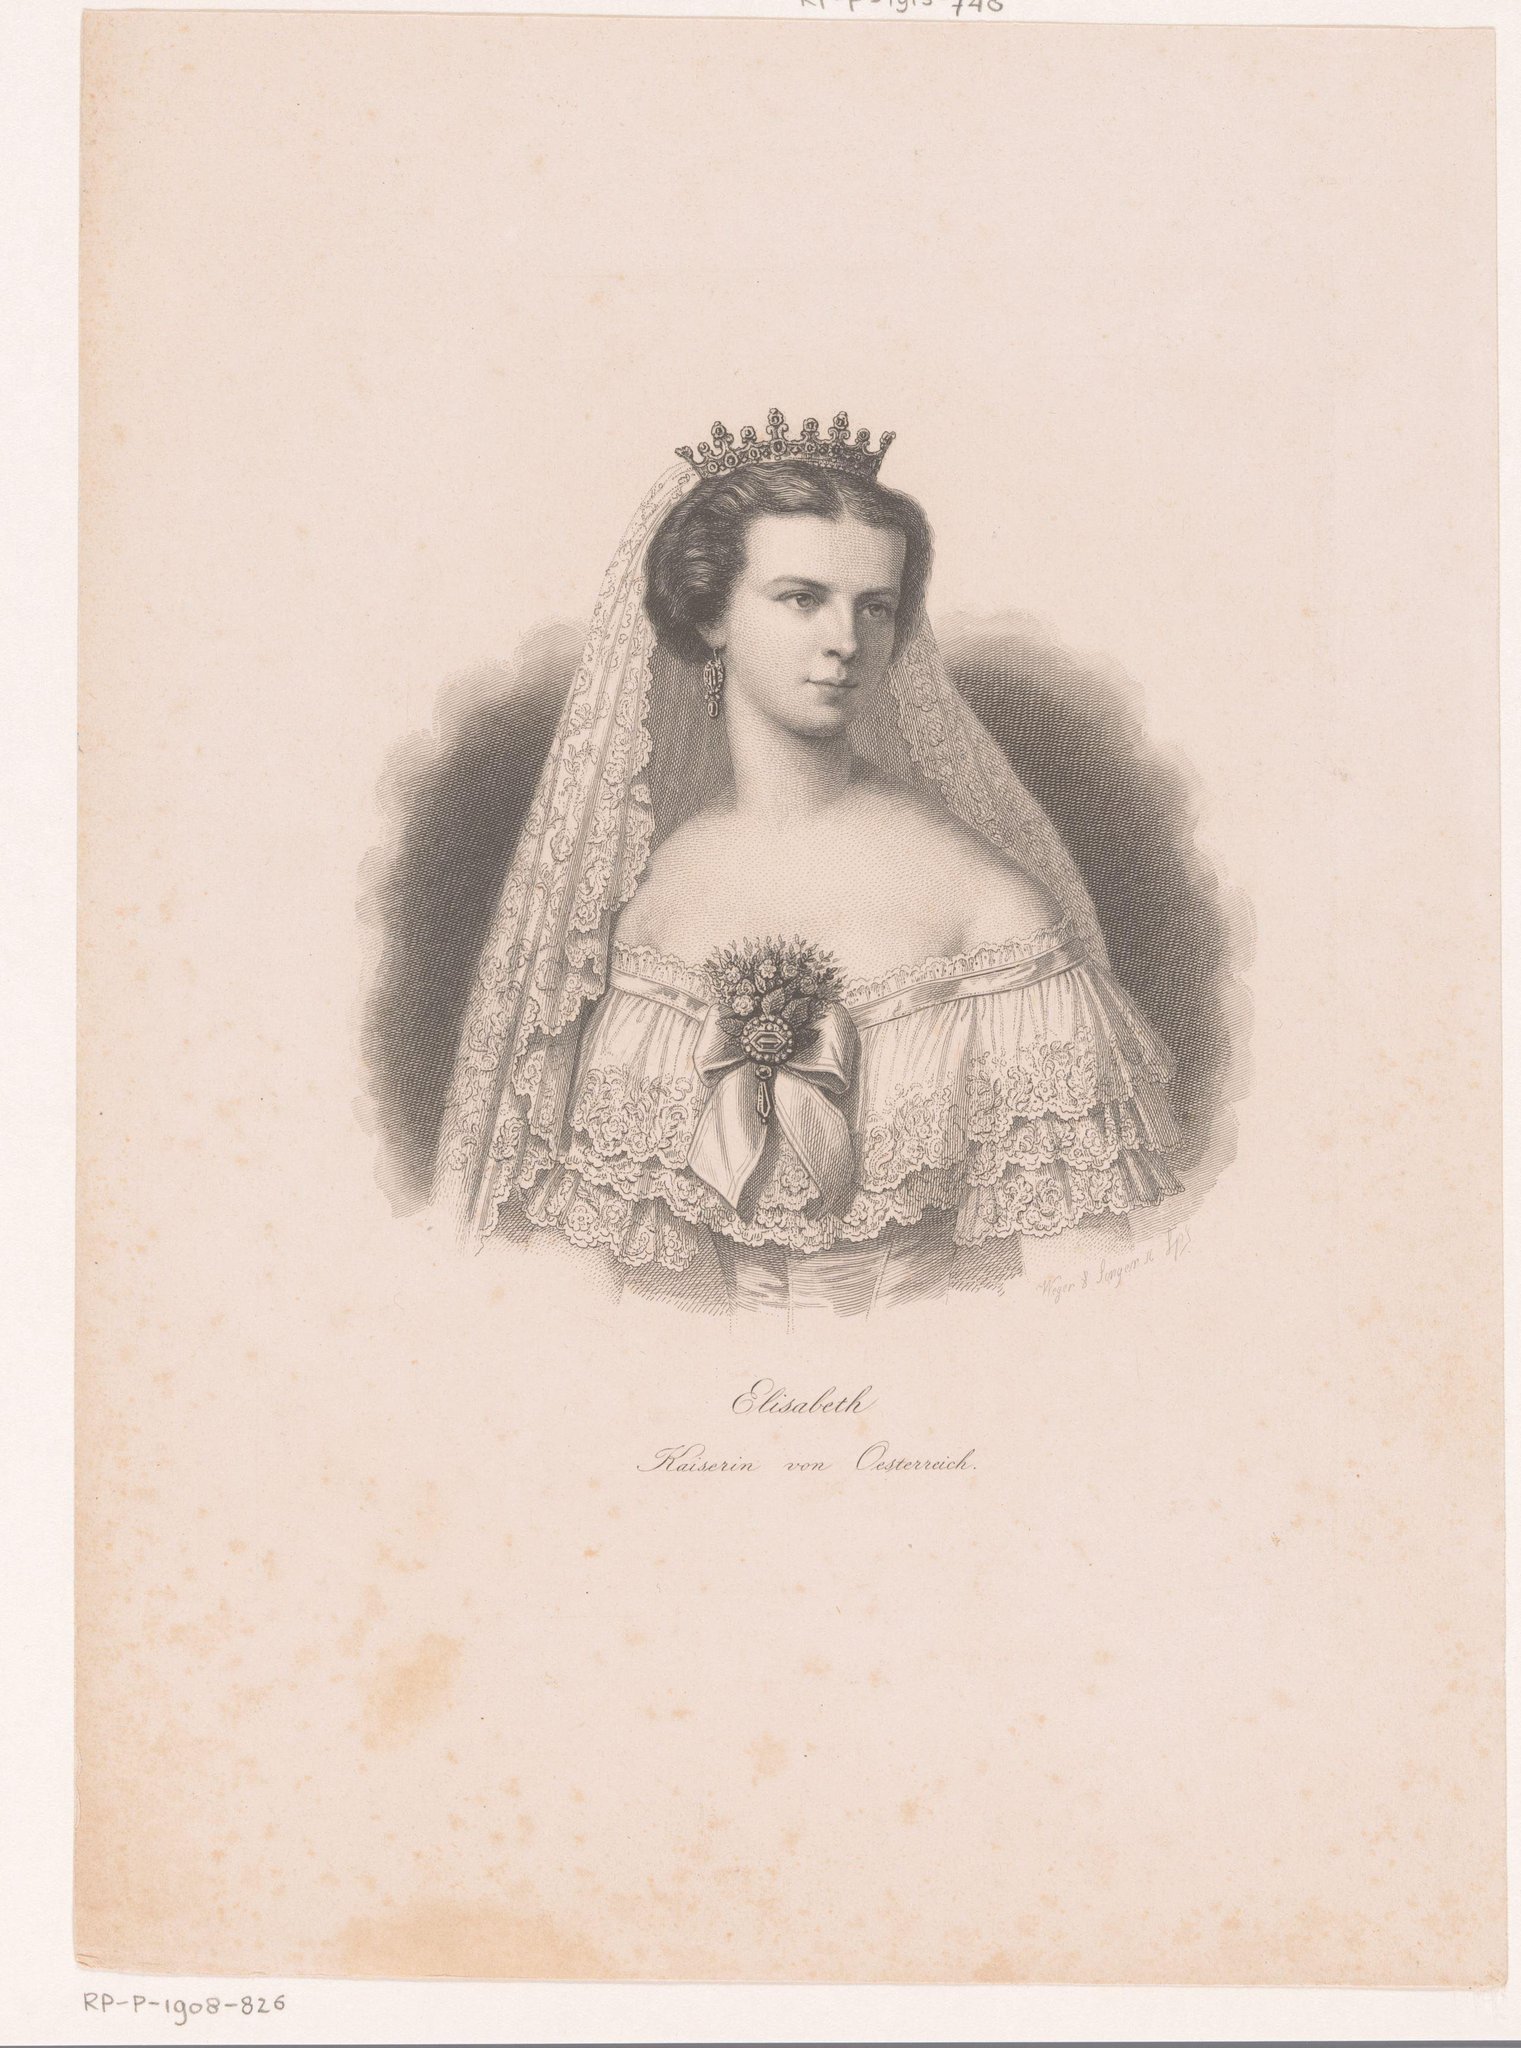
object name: print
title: Portret van Elisabeth Amalie Eugenie in Beieren, keizerin van Oostenrijk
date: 1849-1892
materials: paper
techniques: engraving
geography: leipzig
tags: historical persons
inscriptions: collector's mark: Lugt 2228